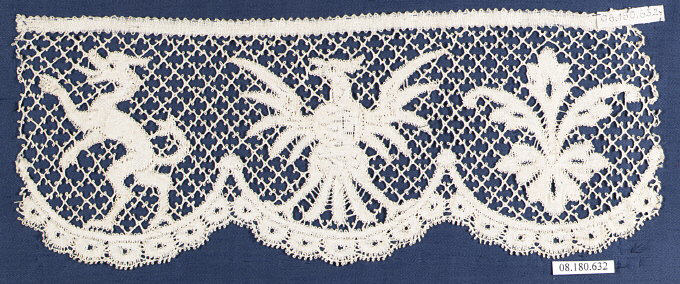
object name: piece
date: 1801-1900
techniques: lace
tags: eagles,griffins